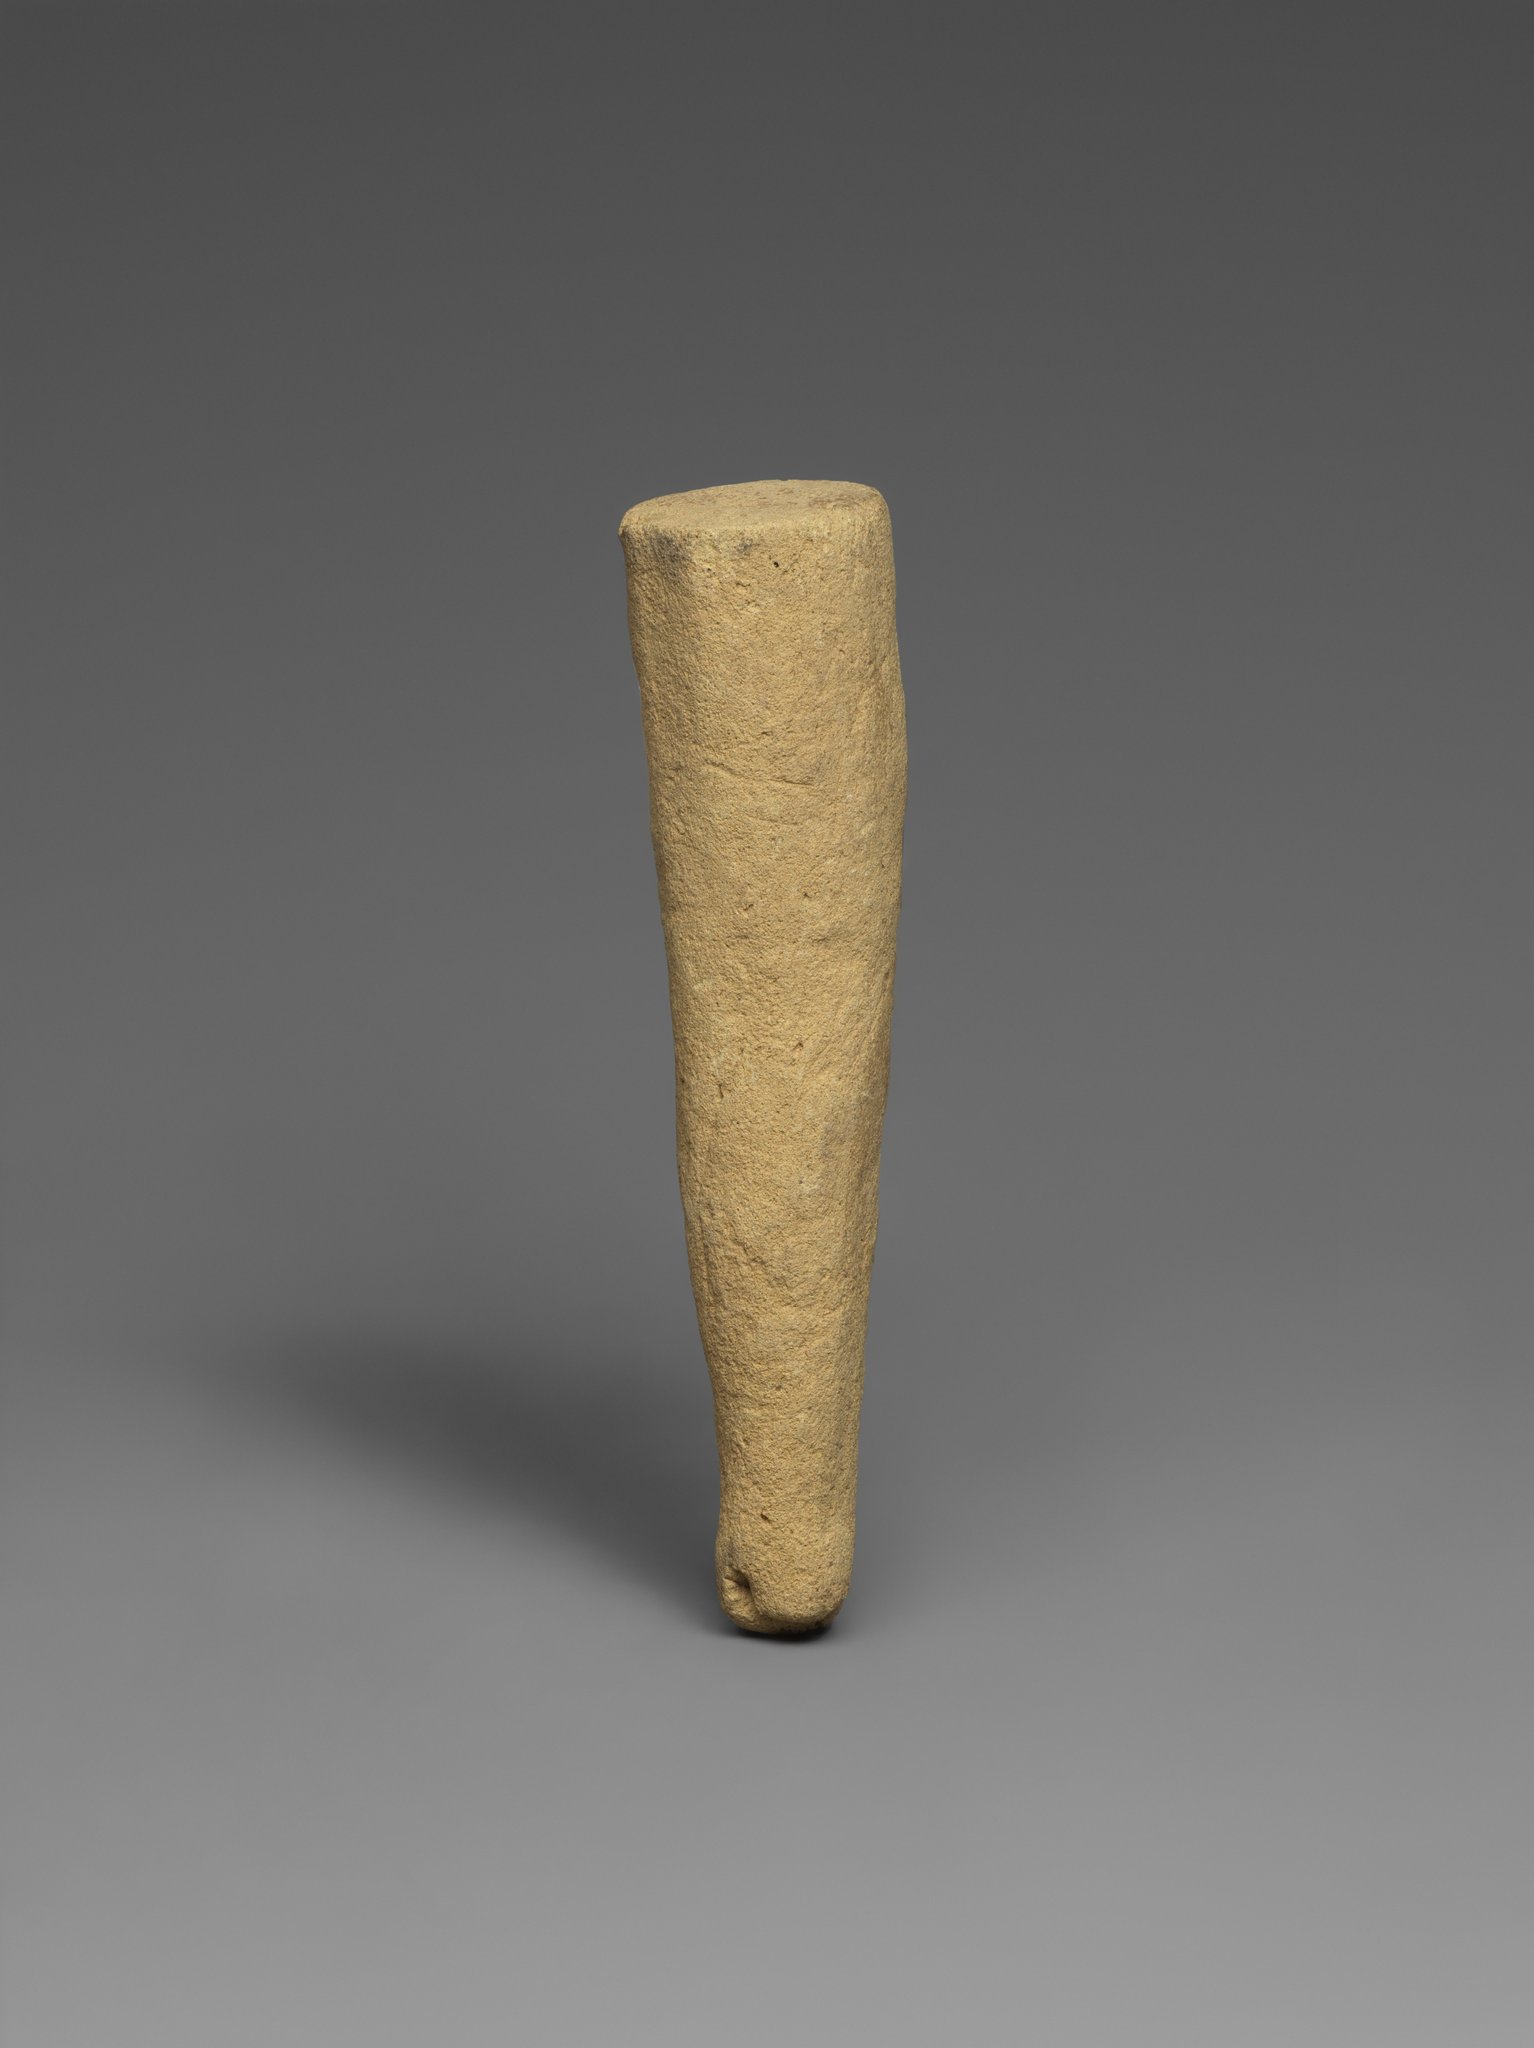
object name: mosaic cone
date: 3100-2900 BCE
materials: ceramic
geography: mesopotamia